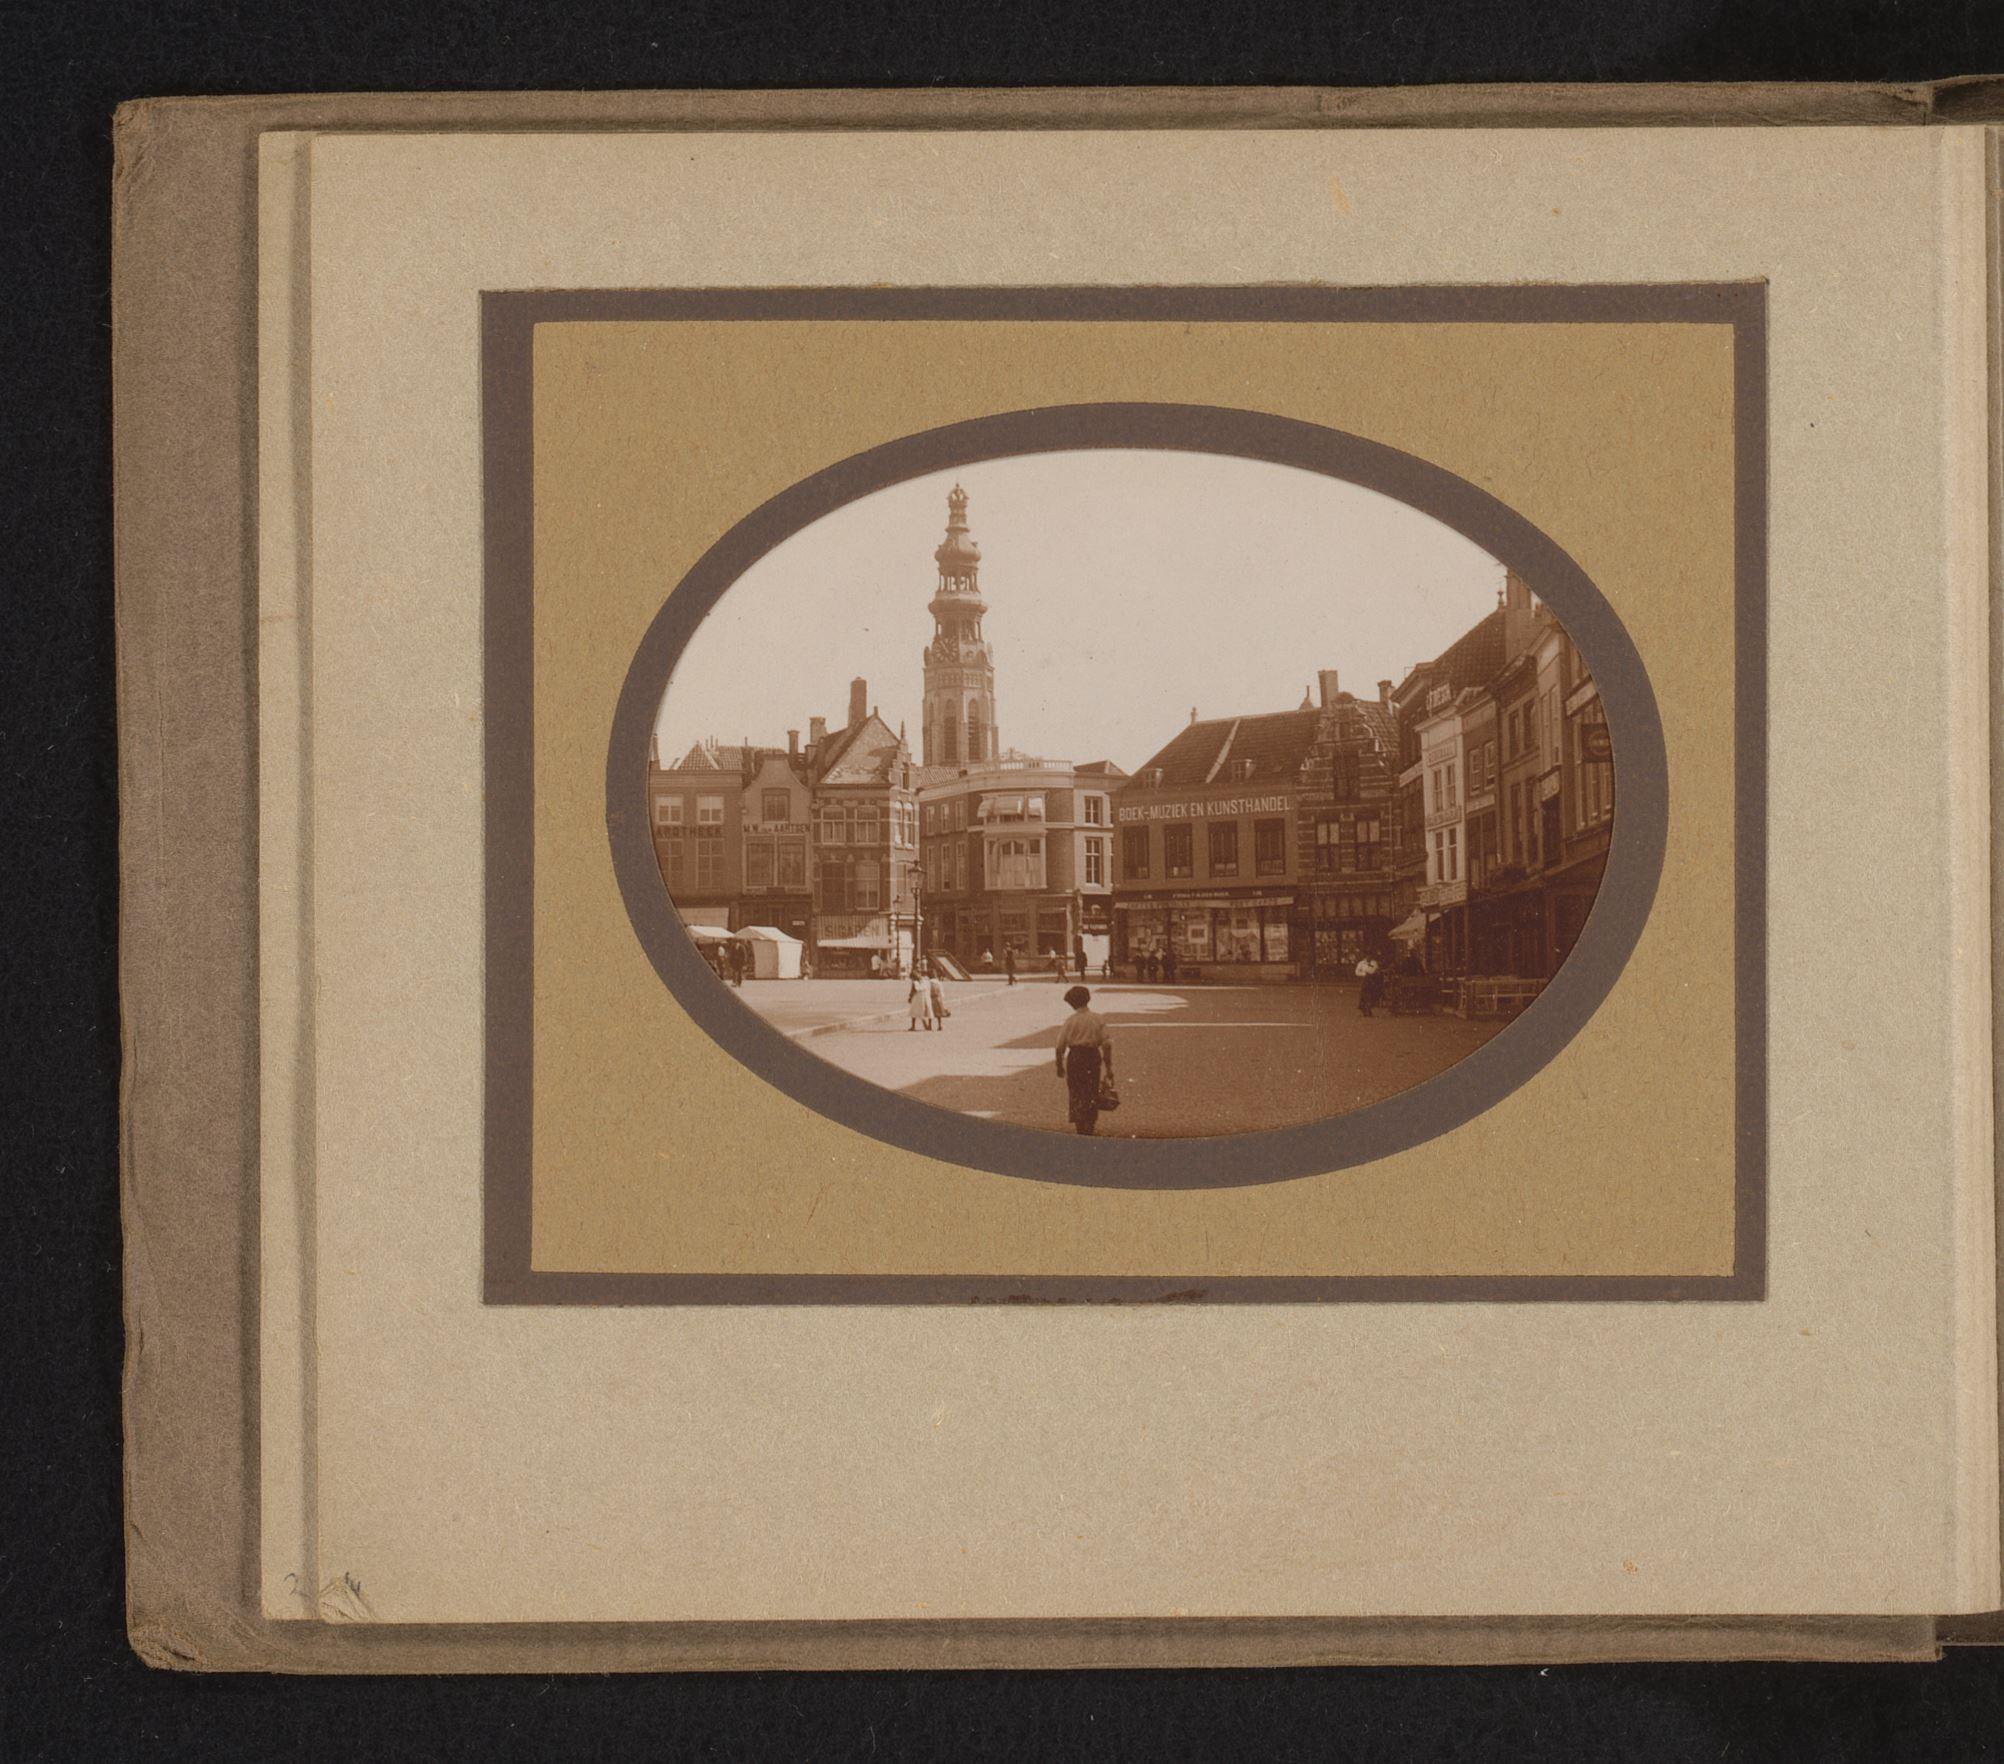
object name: album leaf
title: Gezicht op plein met een kerktoren op de achtergrond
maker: Anonymous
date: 1900-1930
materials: photographic support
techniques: matte daylight collodion silver print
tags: village square, place, parts of church exterior and annexes: tower